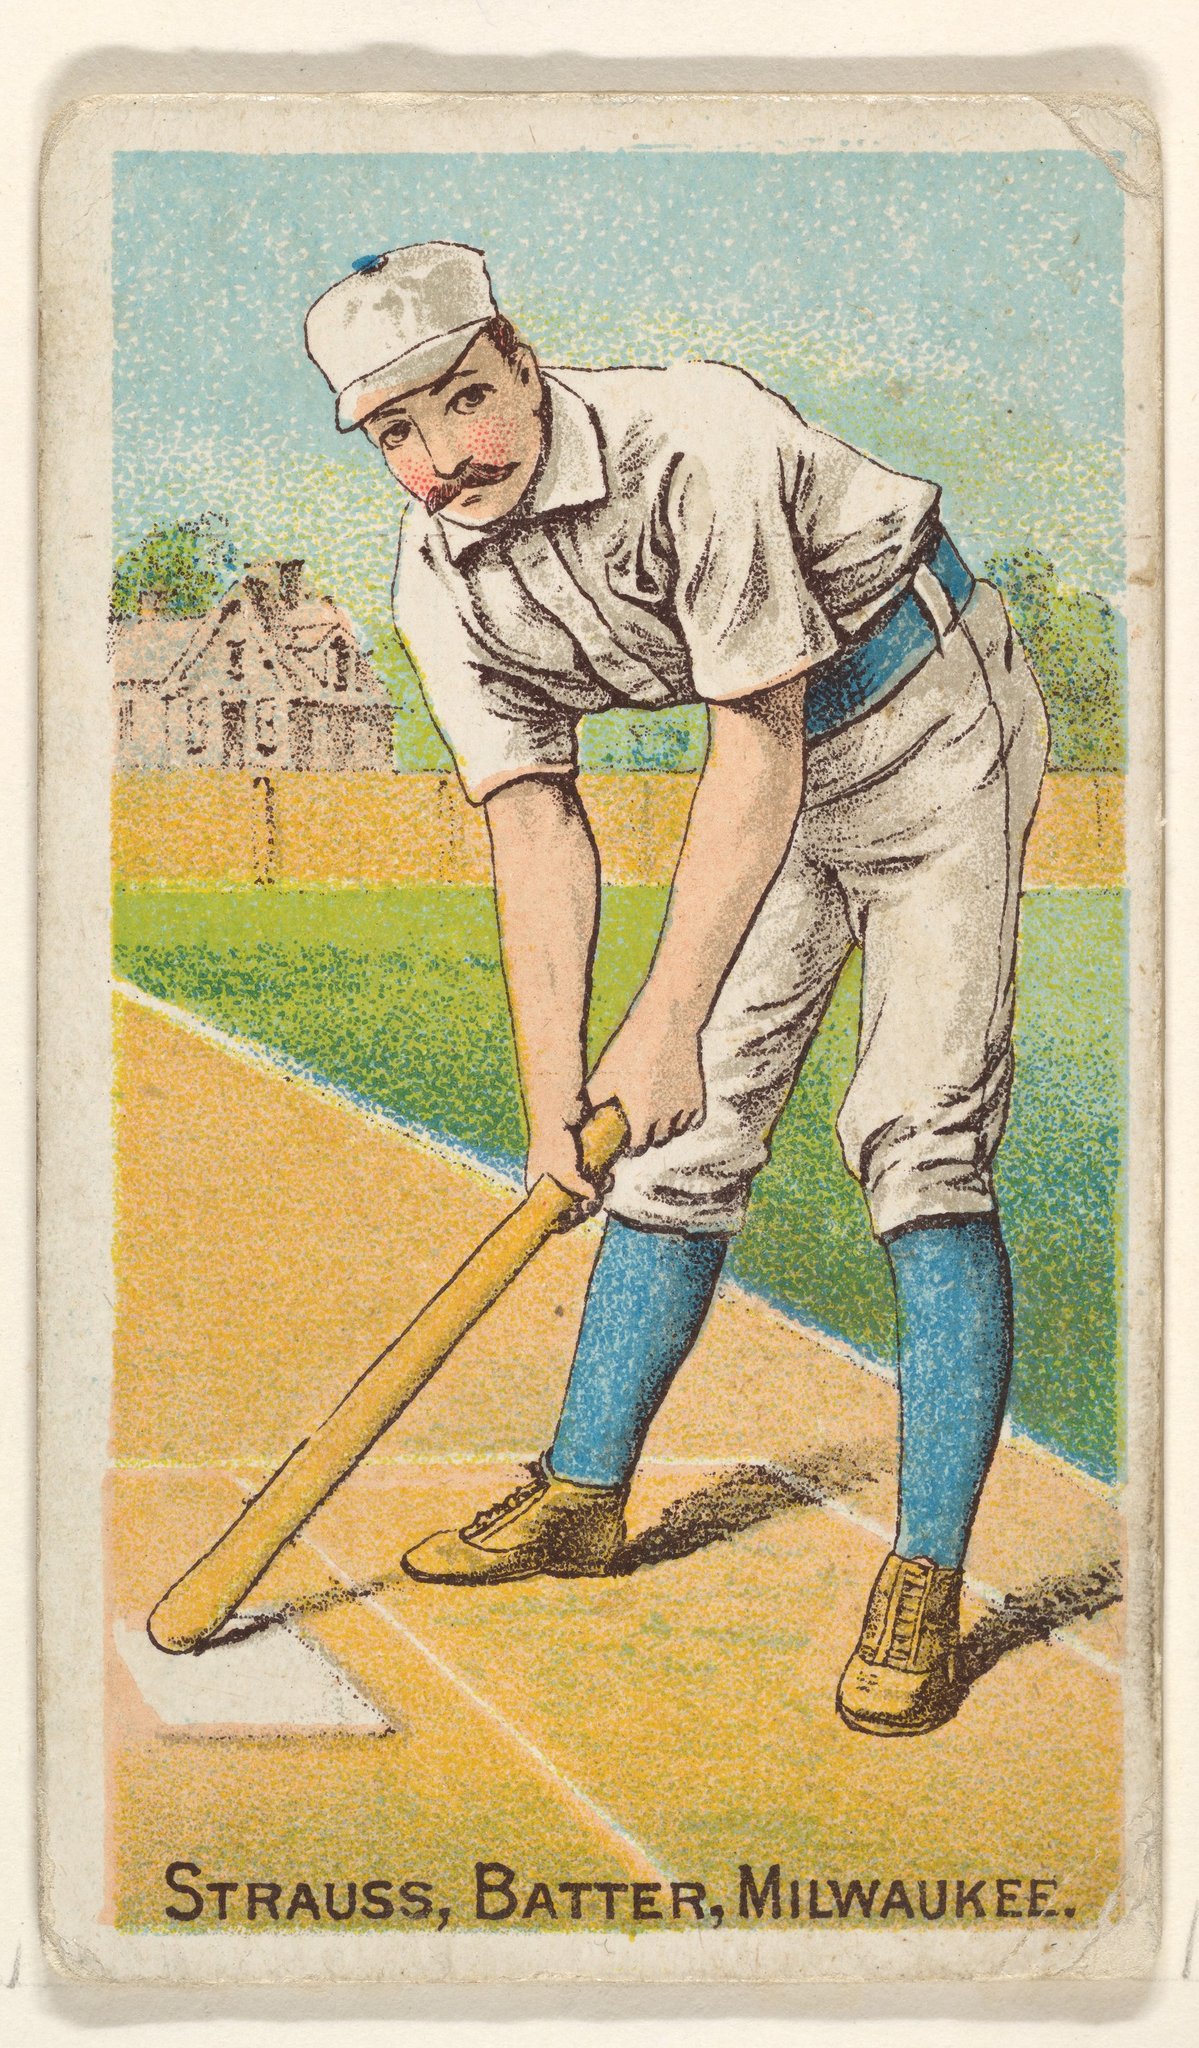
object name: baseball card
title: Strauss, Batter, Milwaukee, from the Gold Coin series (N284) for Gold Coin Chewing Tobacco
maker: d. buchner & co., new york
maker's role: publisher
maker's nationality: american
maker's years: 1850-1900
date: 1887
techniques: color lithograph, drawing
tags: men,baseball,athletes